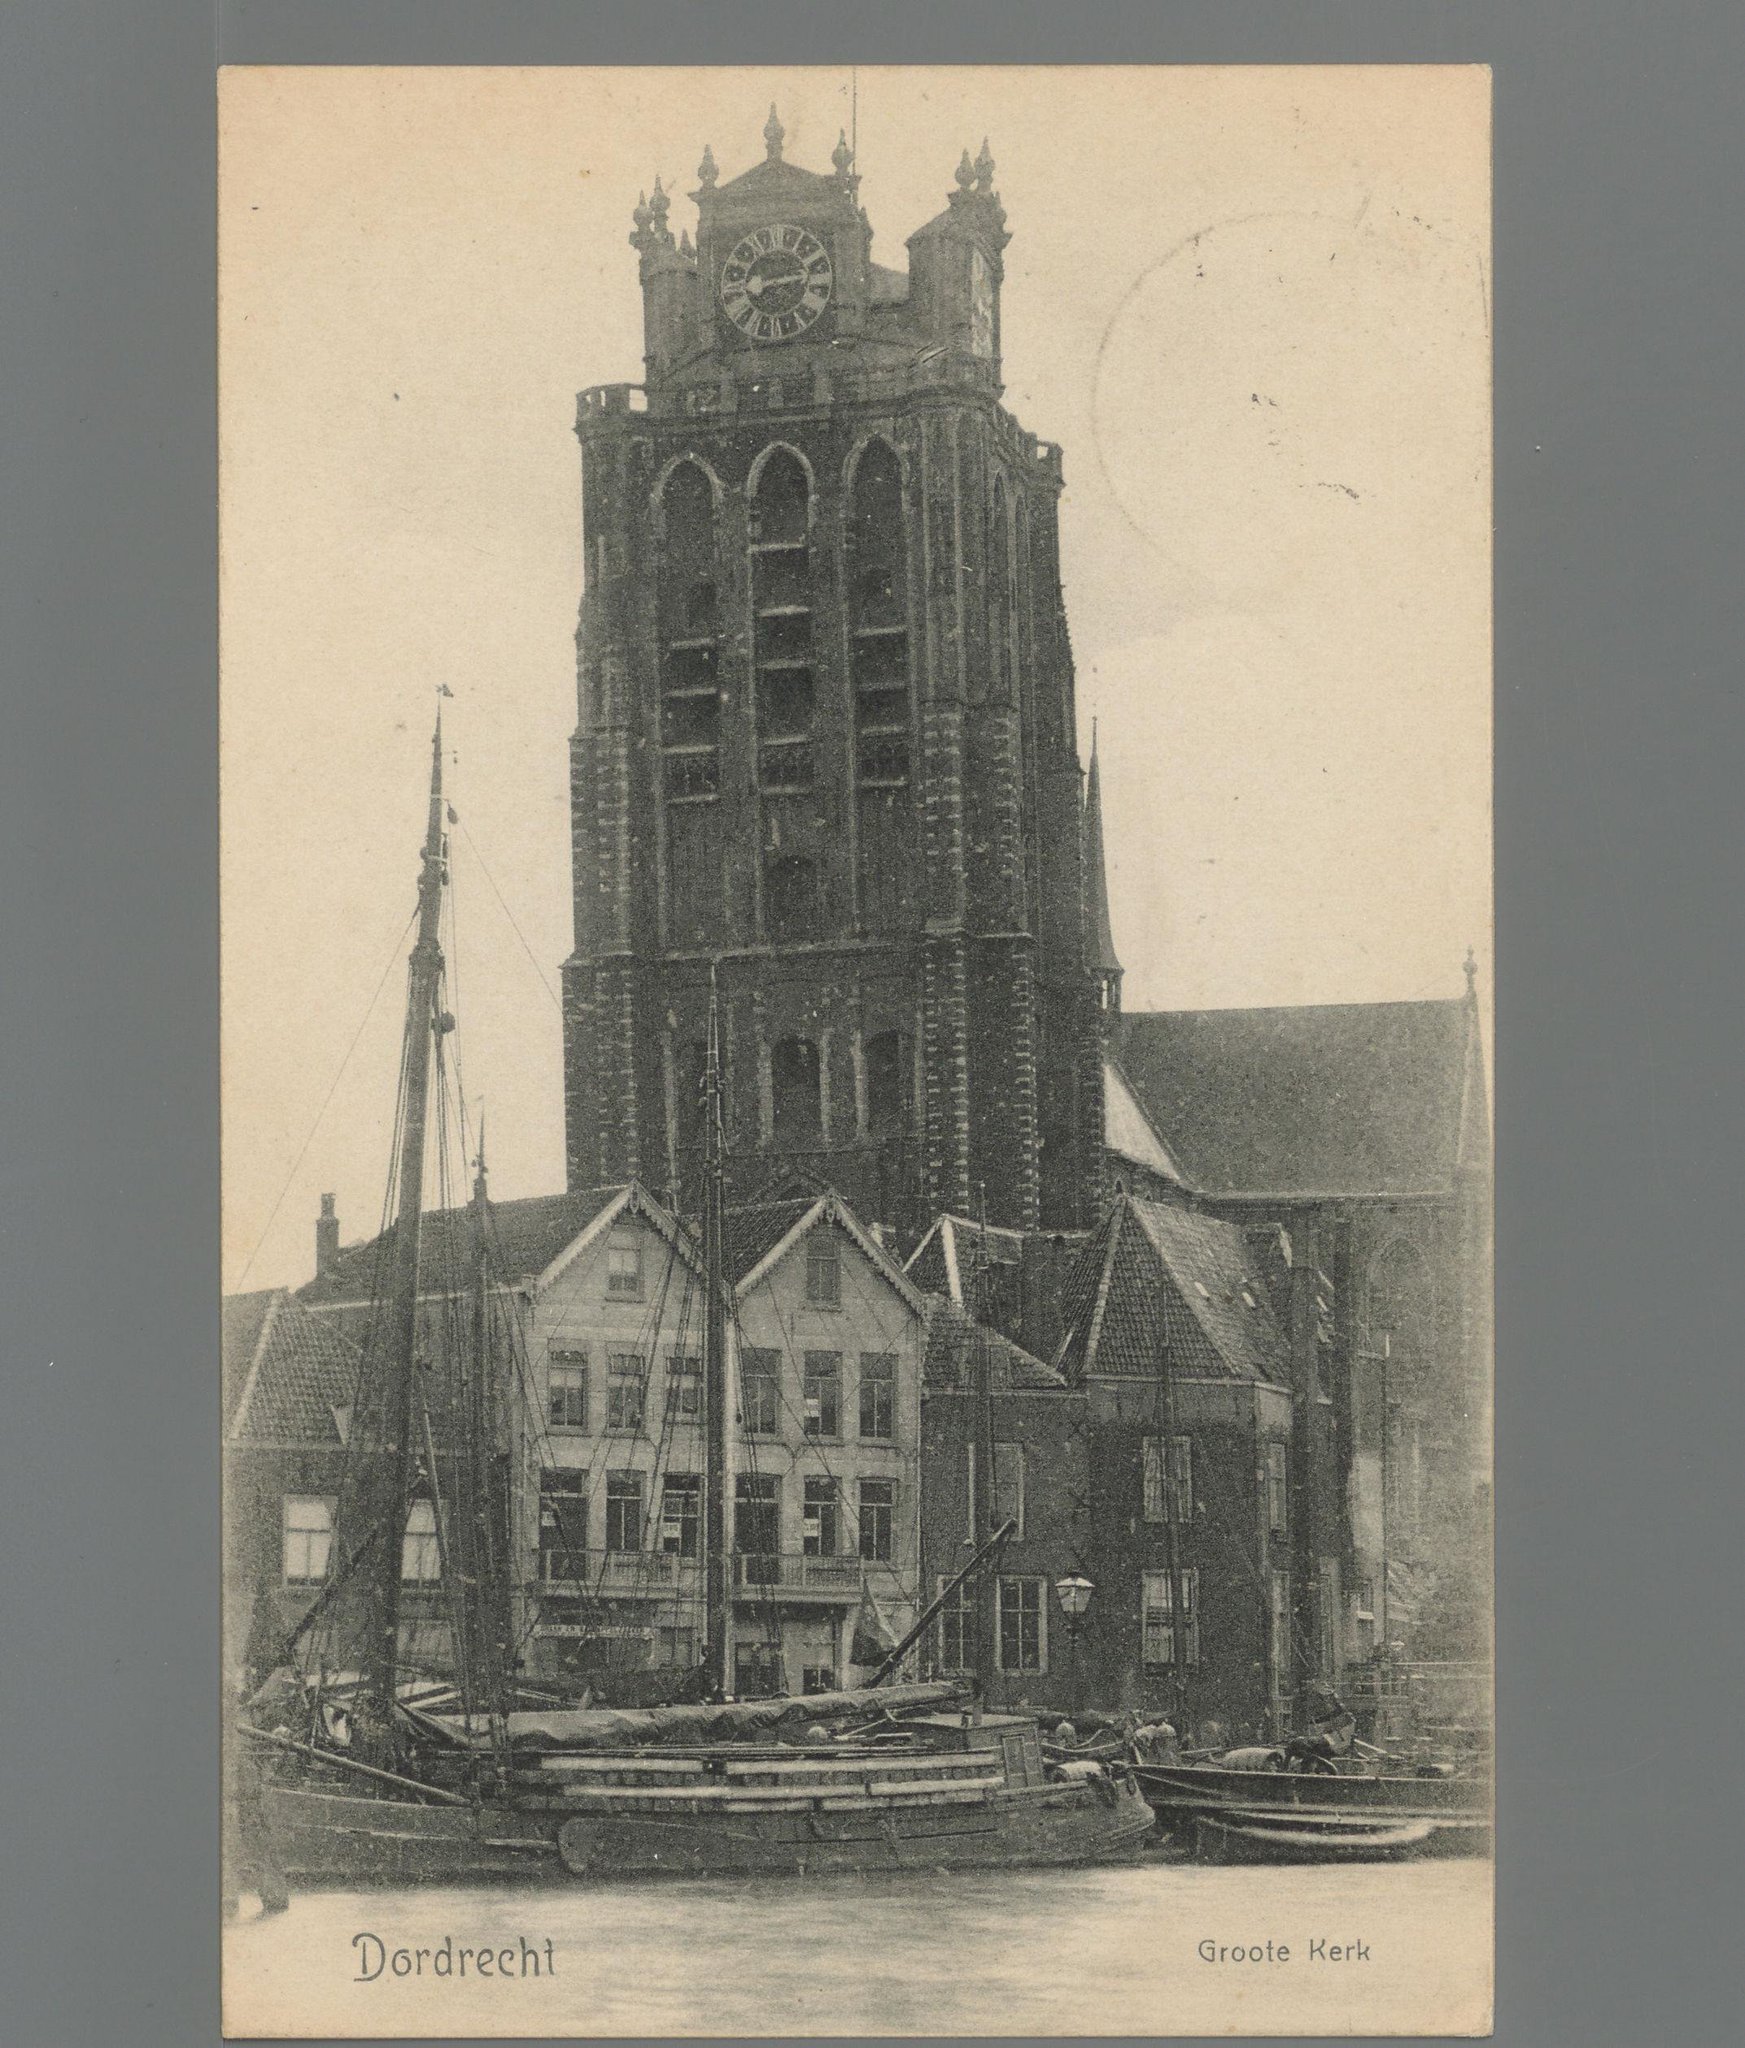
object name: photomechanical print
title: Dordrecht Groote Kerk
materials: cardboard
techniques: photograph, writing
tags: church (exterior), dordrecht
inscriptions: postage stamp